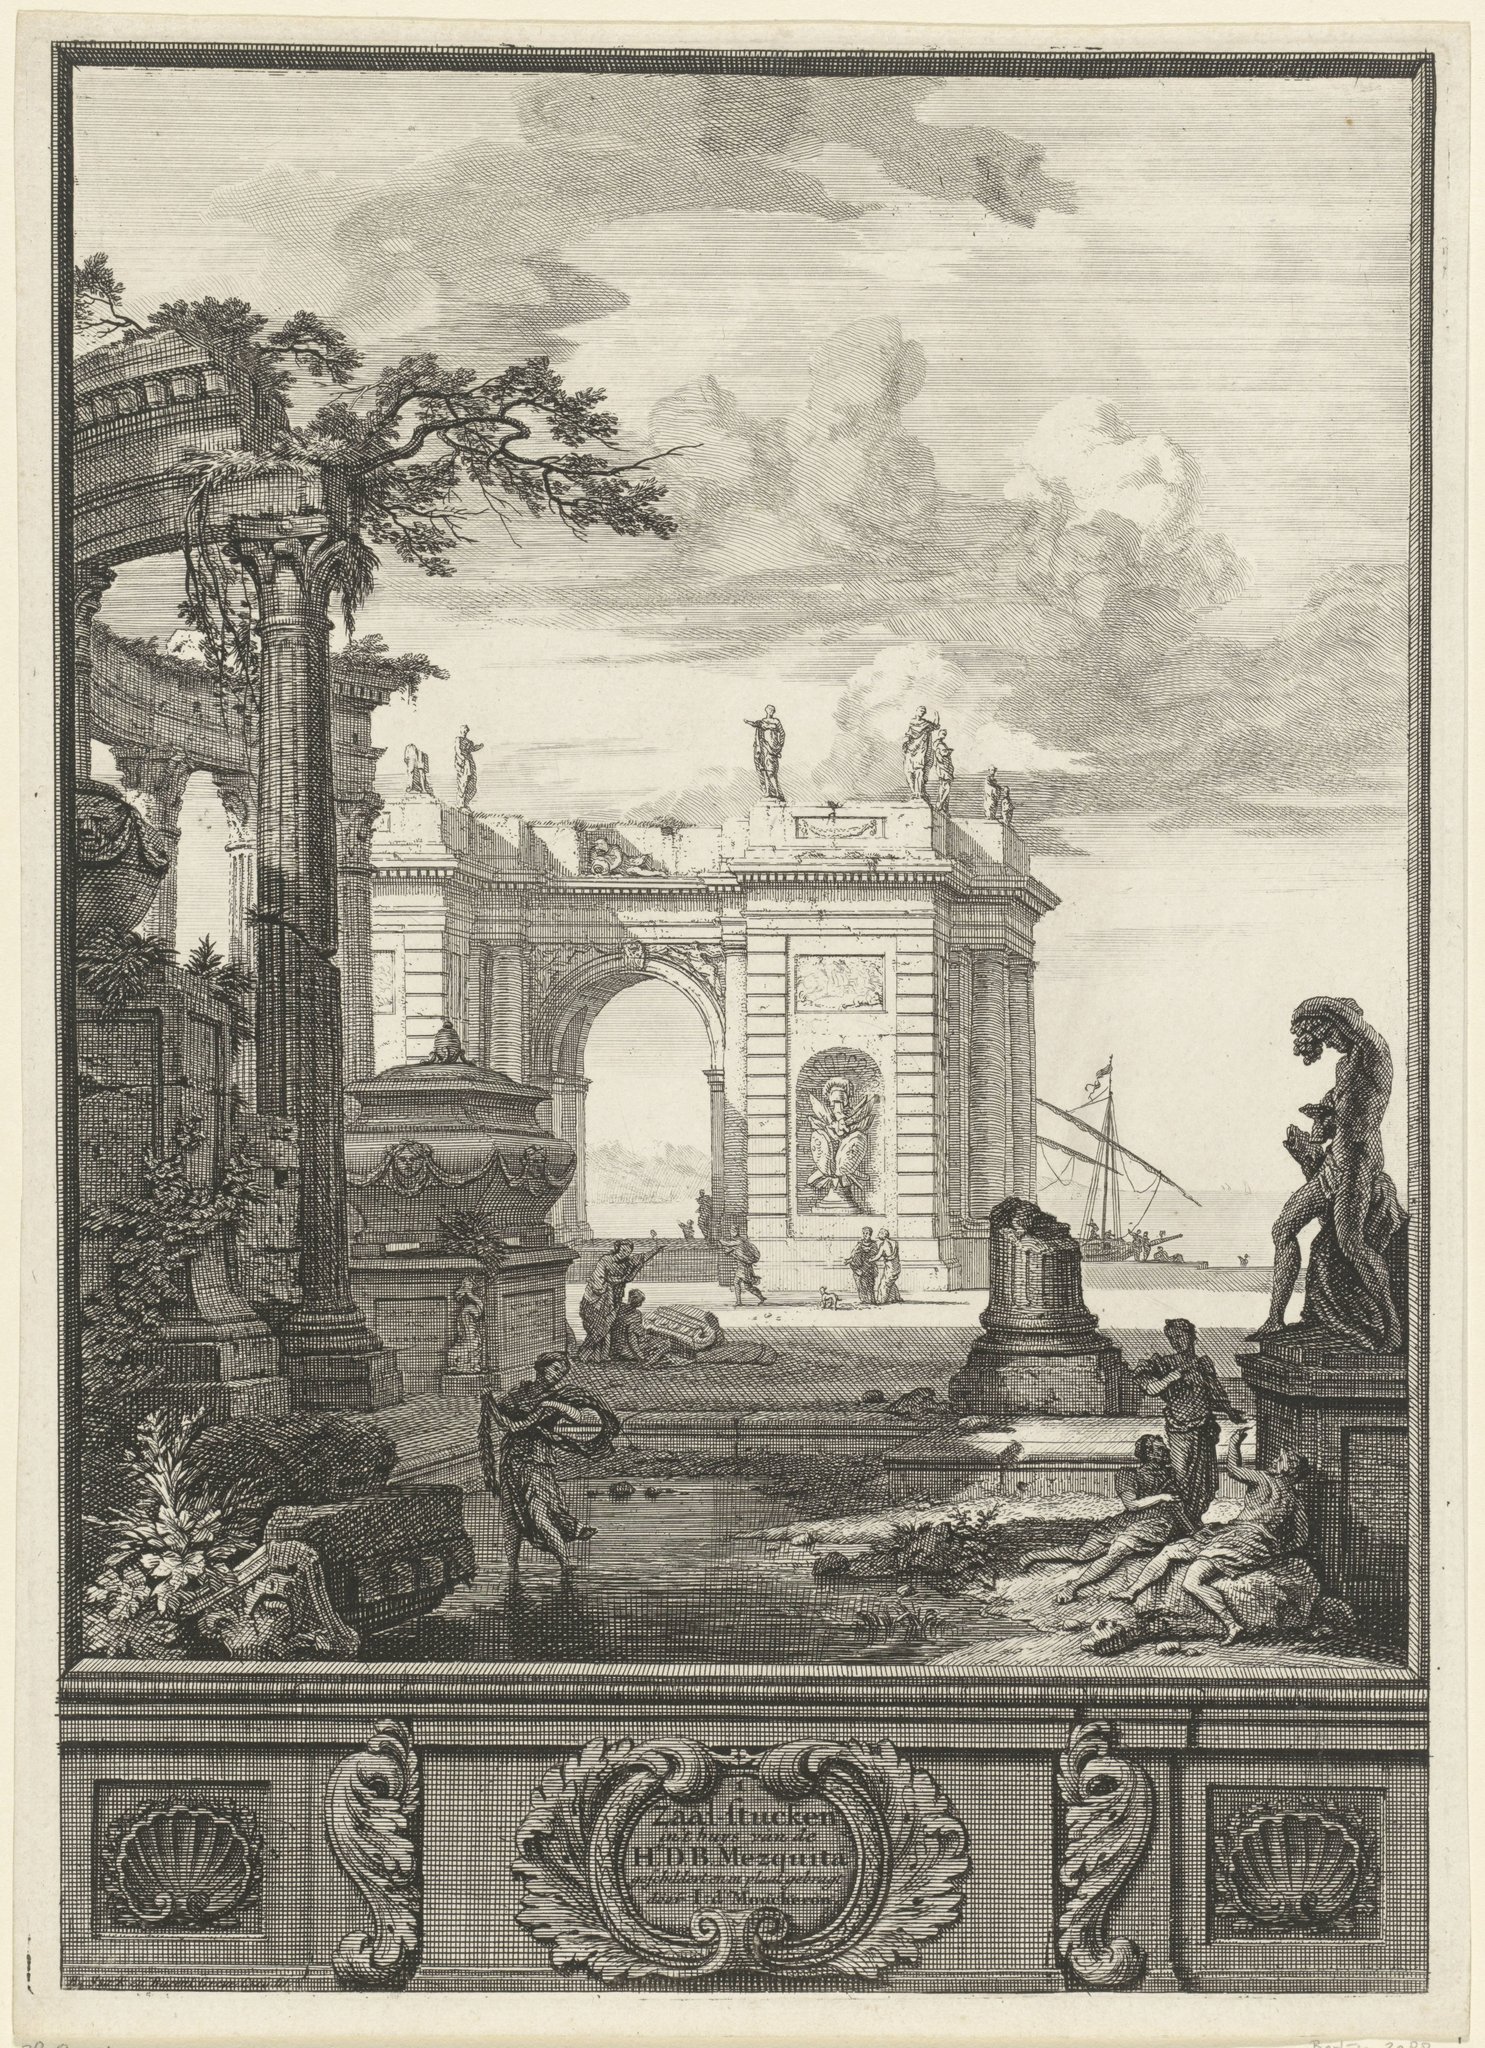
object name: print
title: Zaalstukken in het huis van de heer Mesquita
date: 1677-1744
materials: paper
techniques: engraving, etching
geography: amsterdam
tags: triumphal arch, landscape with ruins, piece of sculpture, reproduction of a piece of sculpture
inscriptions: collector's mark: Lugt 2228, collector's mark: Lugt 2760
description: Landschap met het overblijfsel van een ronde klassieke tempel links en rechts een sculptuur. Op de voorgrond waadt een figuur door het water, op de kant zitten drie figuren bijeen. Op de achtergrond een triomfboog en een schip aan de kade. Naar het beschilderde muurpaneel in de zaal van het huis van koopman David Bueno de Mesquita.